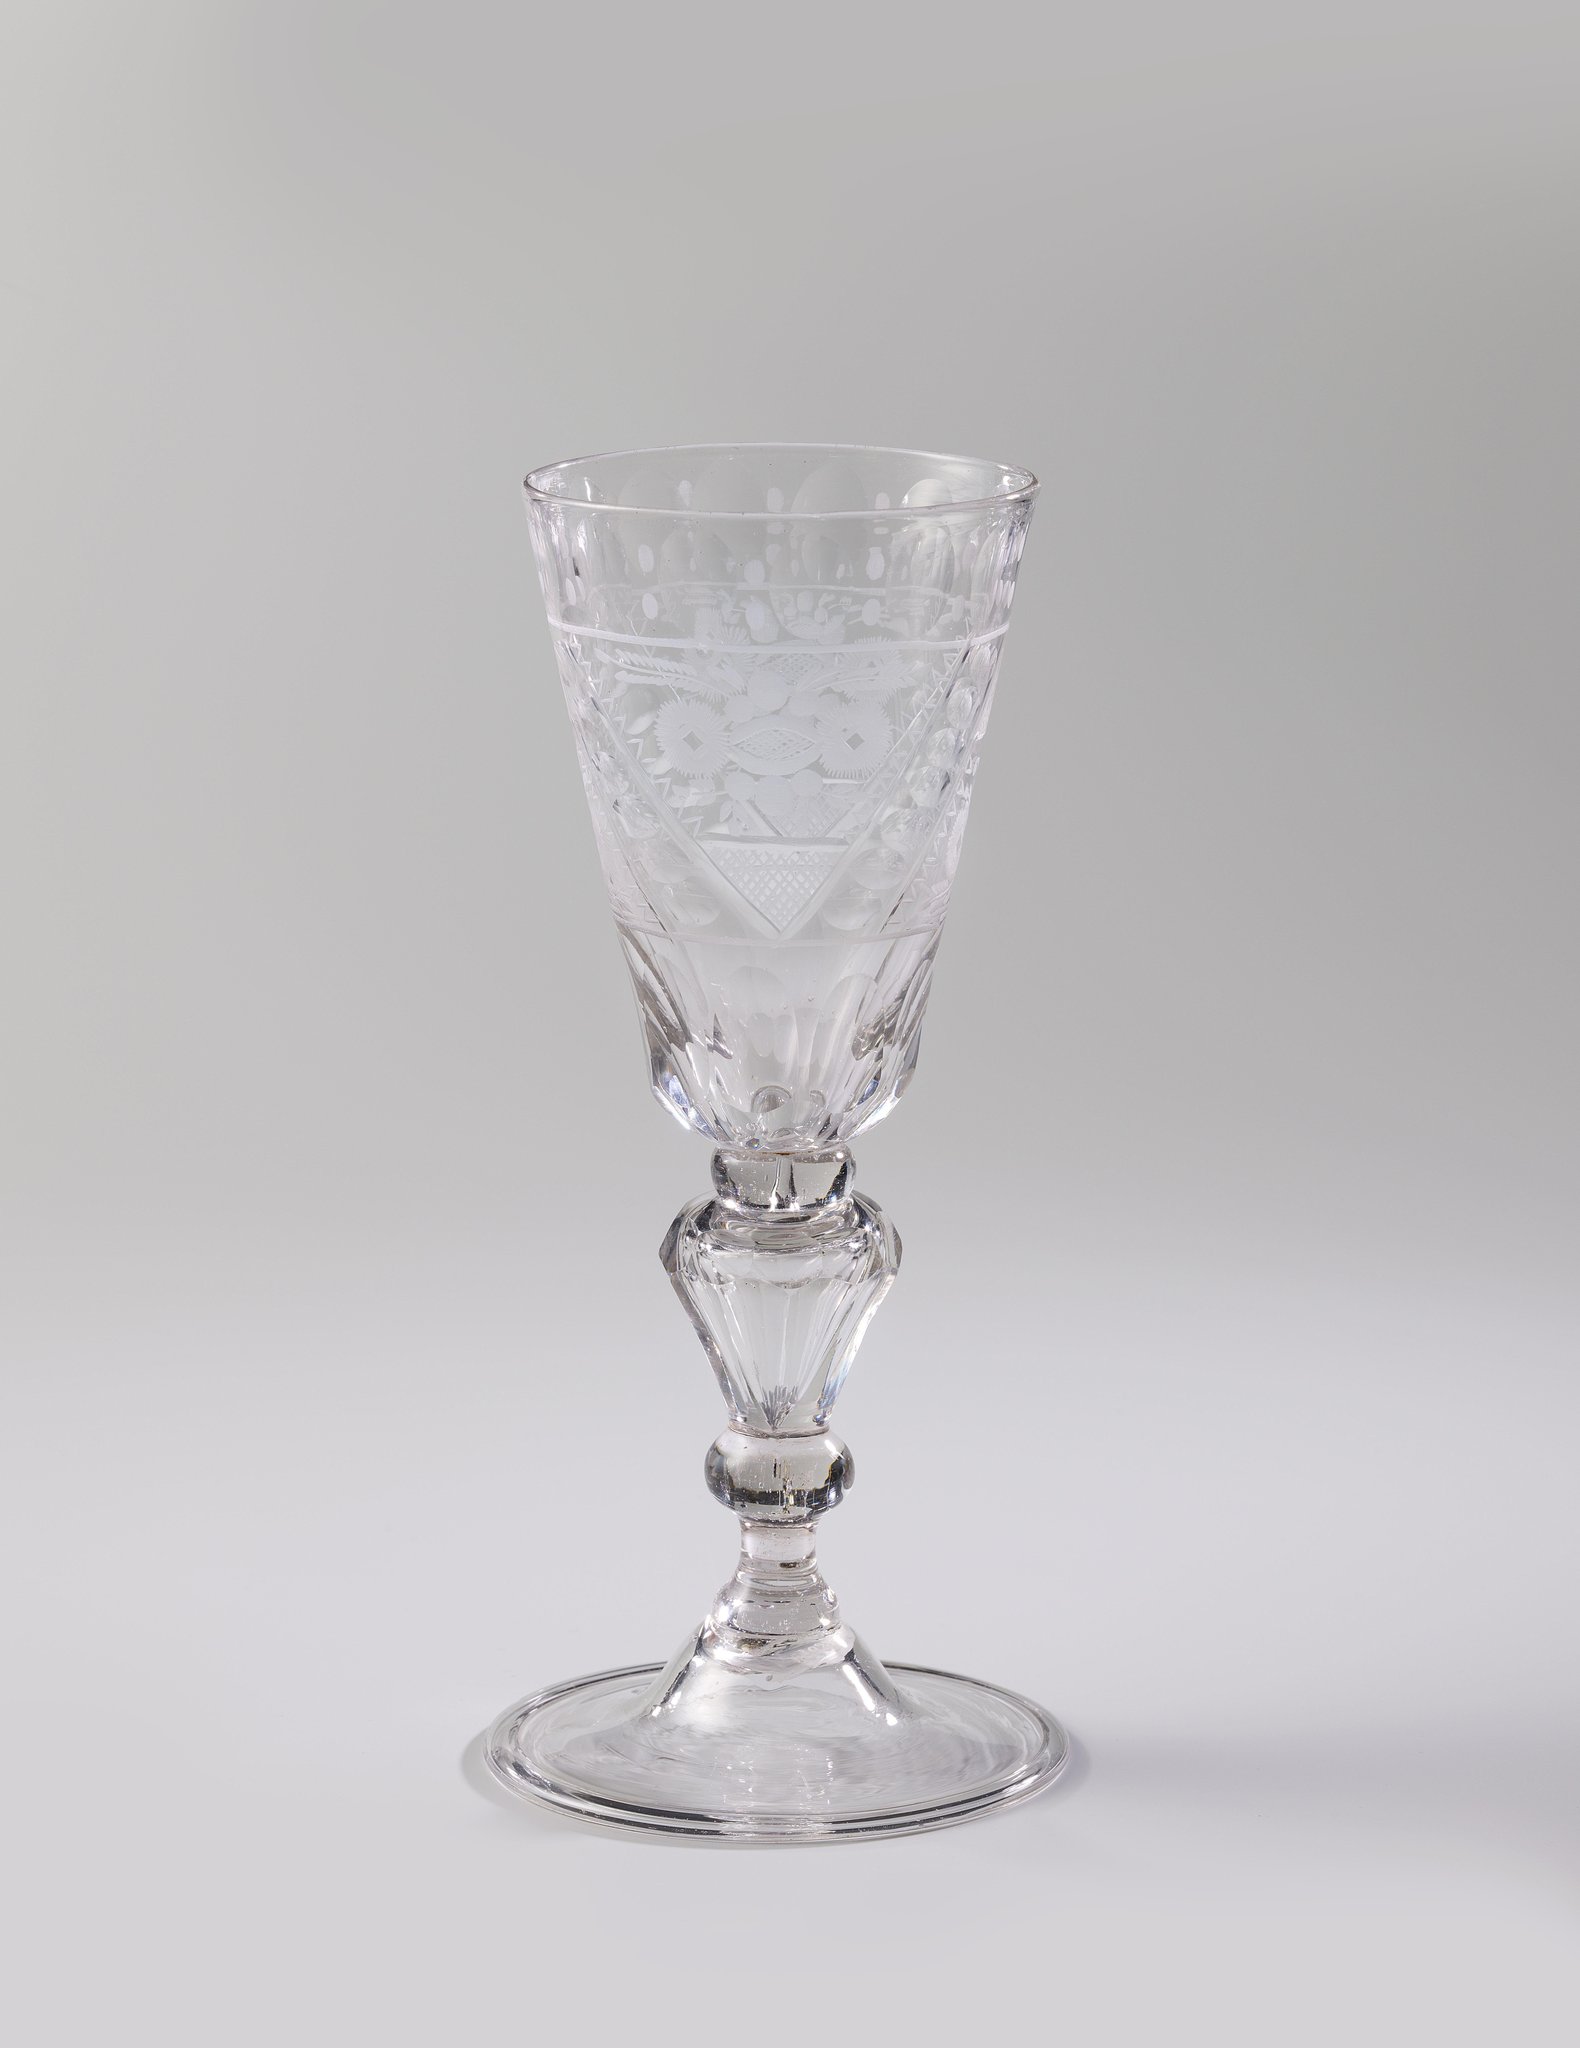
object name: goblet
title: Bokaal met driehoekige velden met gestileerde ranken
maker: Anonymous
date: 1725-1750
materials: glass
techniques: glassblowing, grinding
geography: bohemia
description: Bokaal met een gegraveerde band met driehoekige velden met gestileerde ranken.